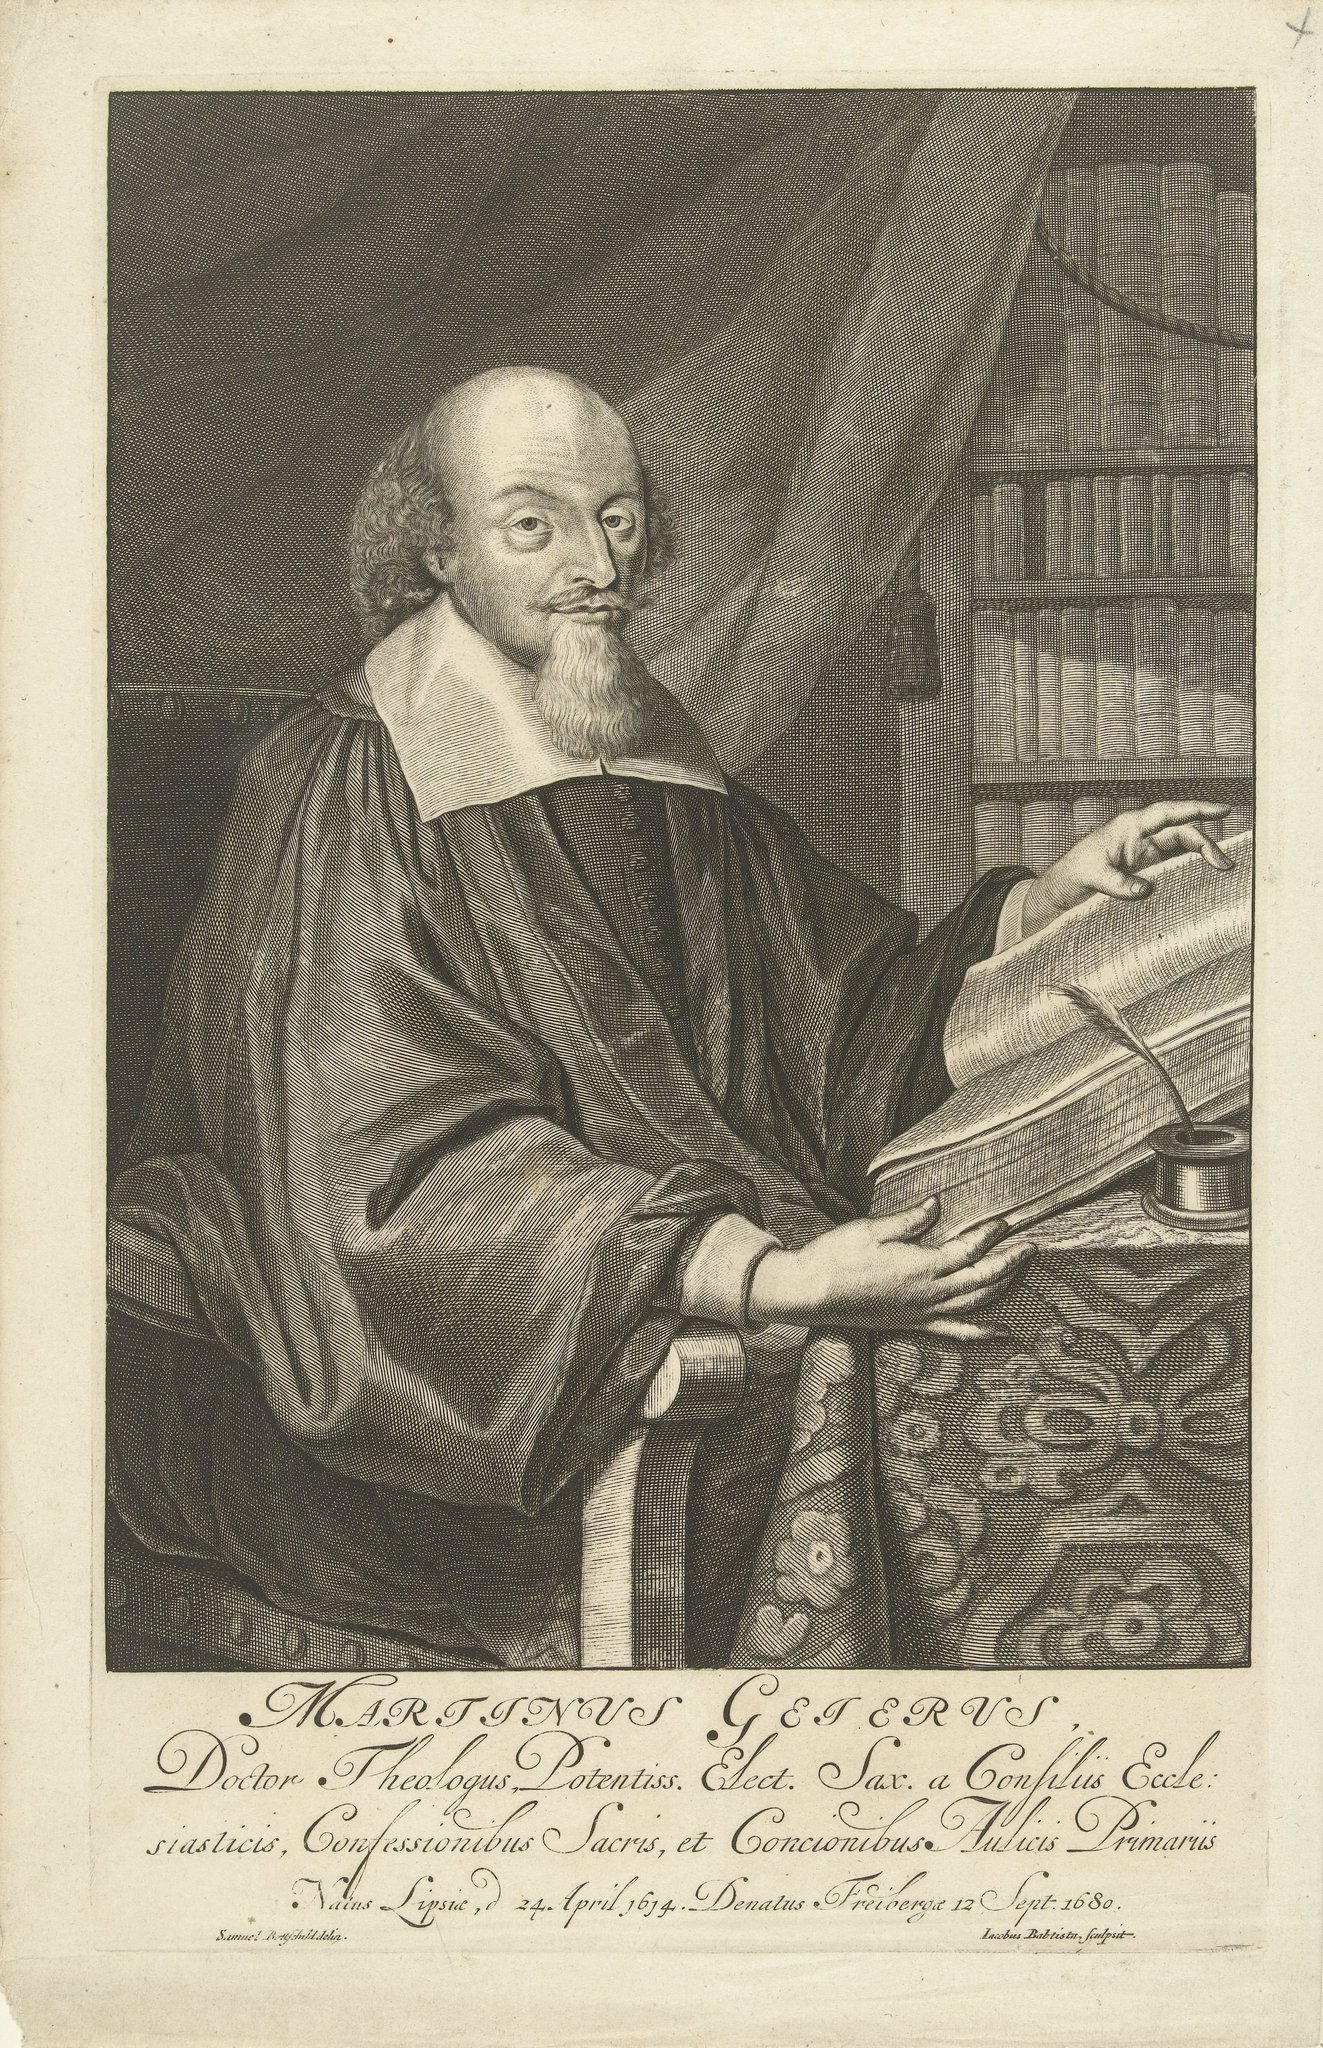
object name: print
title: Portret van Martin Geier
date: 1693-1704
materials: paper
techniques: engraving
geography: amsterdam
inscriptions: collector's mark: Lugt 2228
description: Portret van Martin Geier, onder het portret zijn naam, titels en geboorte en sterfdatum.